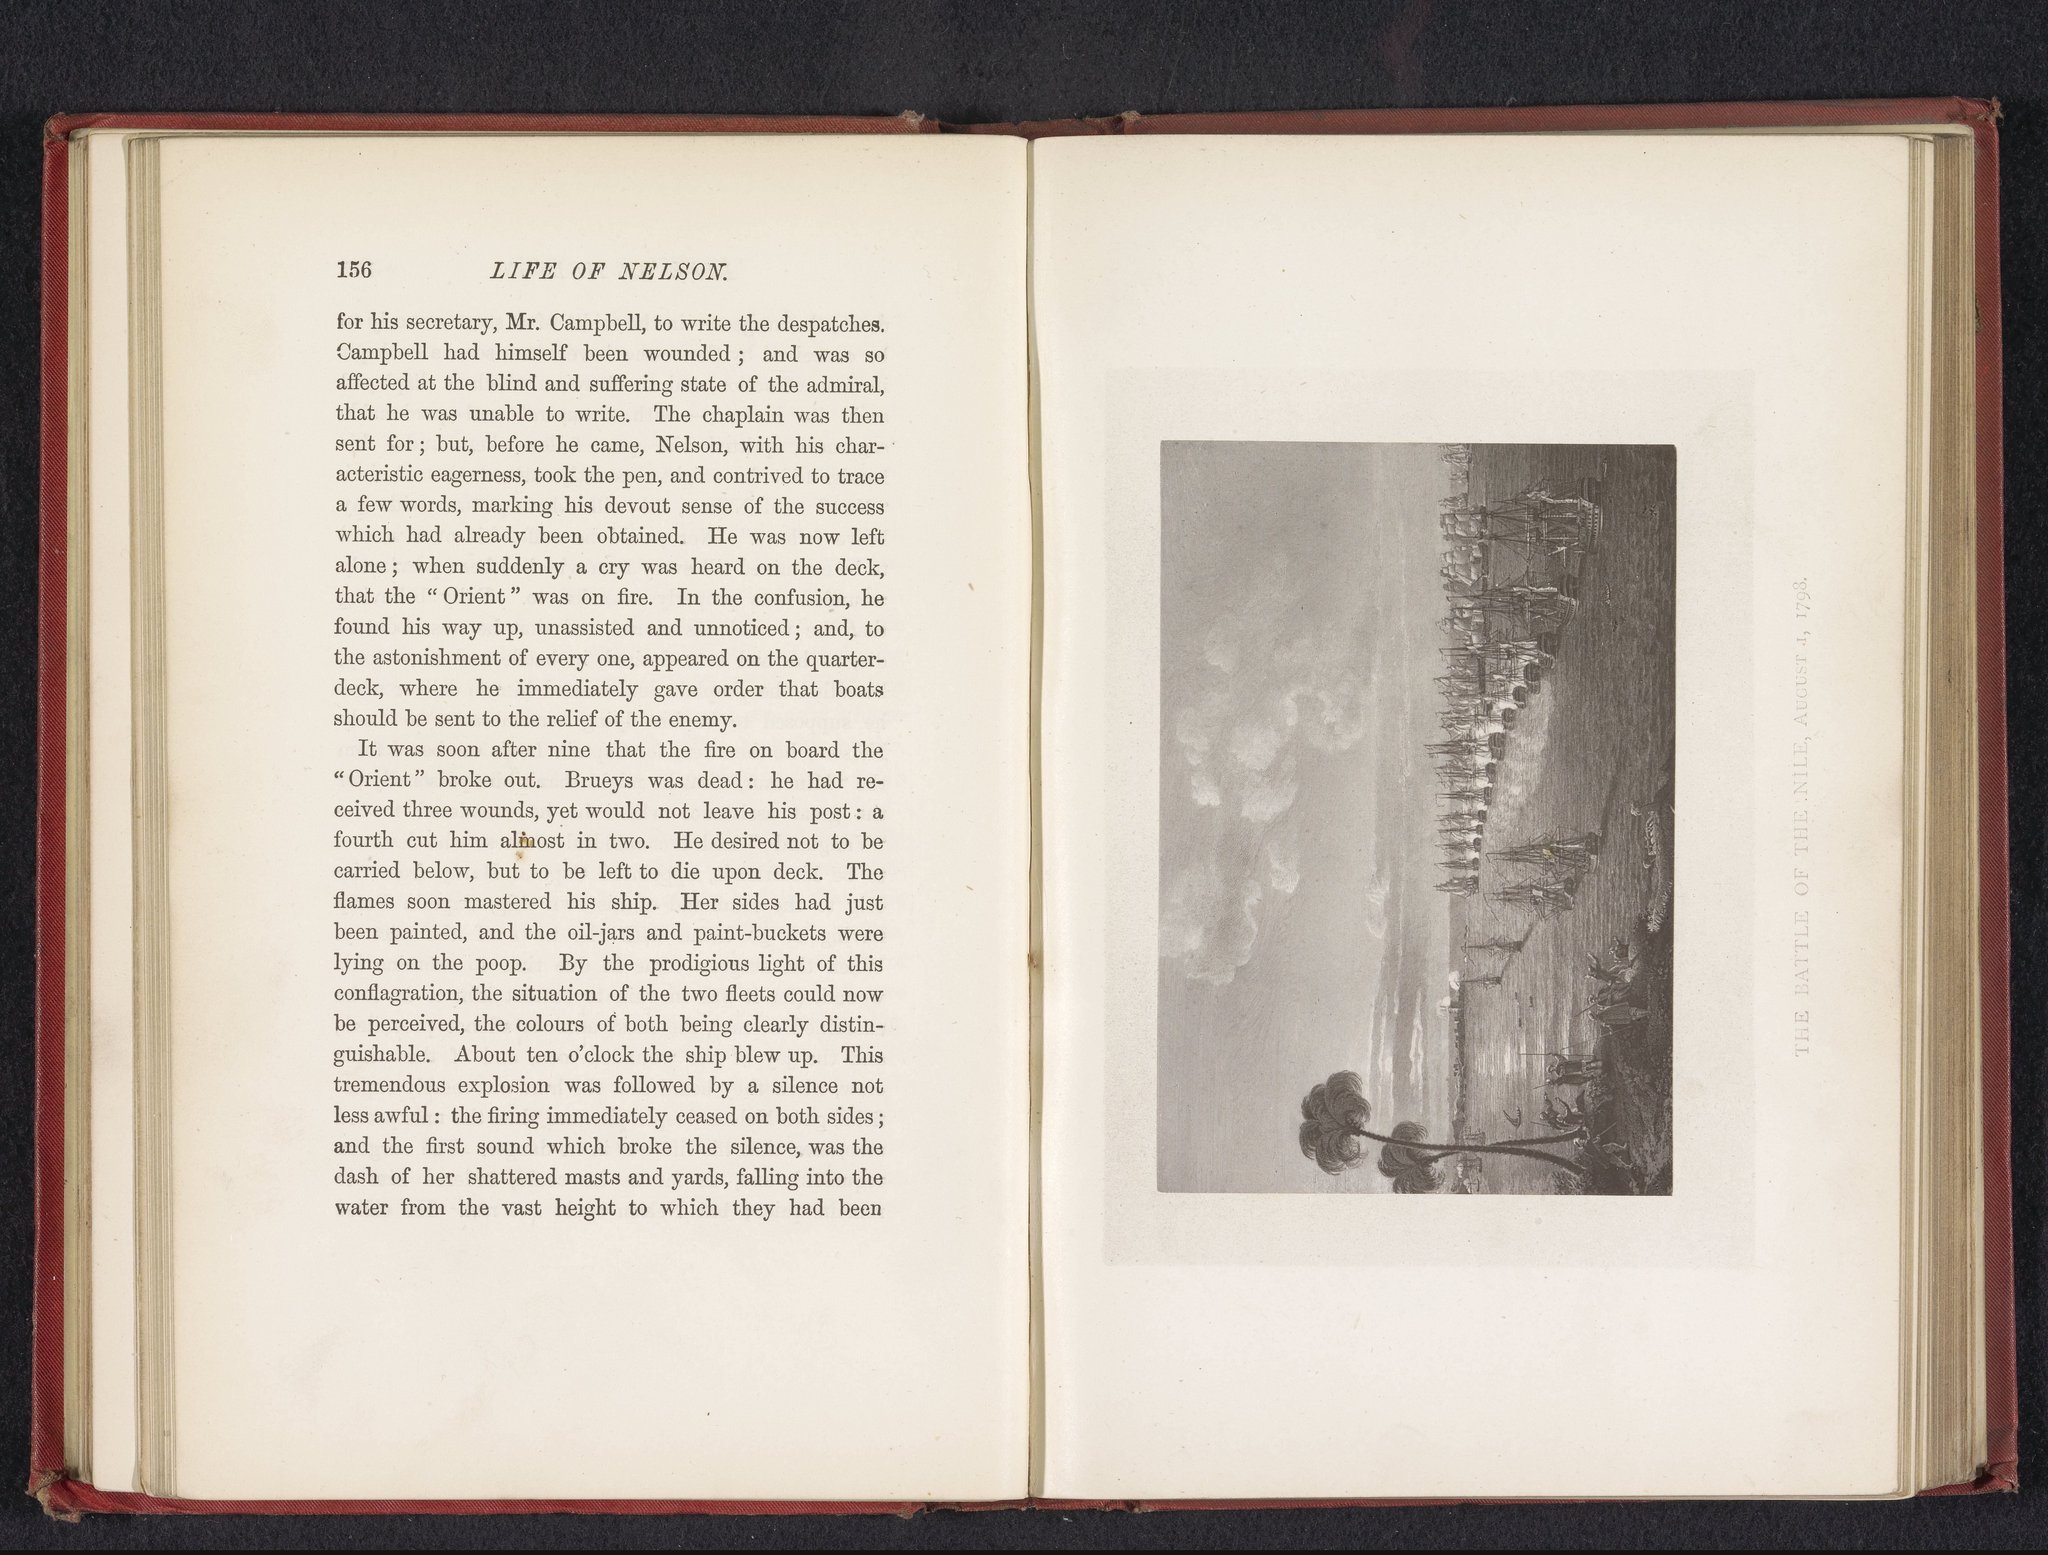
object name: page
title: Fotoreproductie van een prent van de Slag bij de Nijl in 1798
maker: Anonymous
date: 1877-1887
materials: paper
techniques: woodburytype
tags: battle